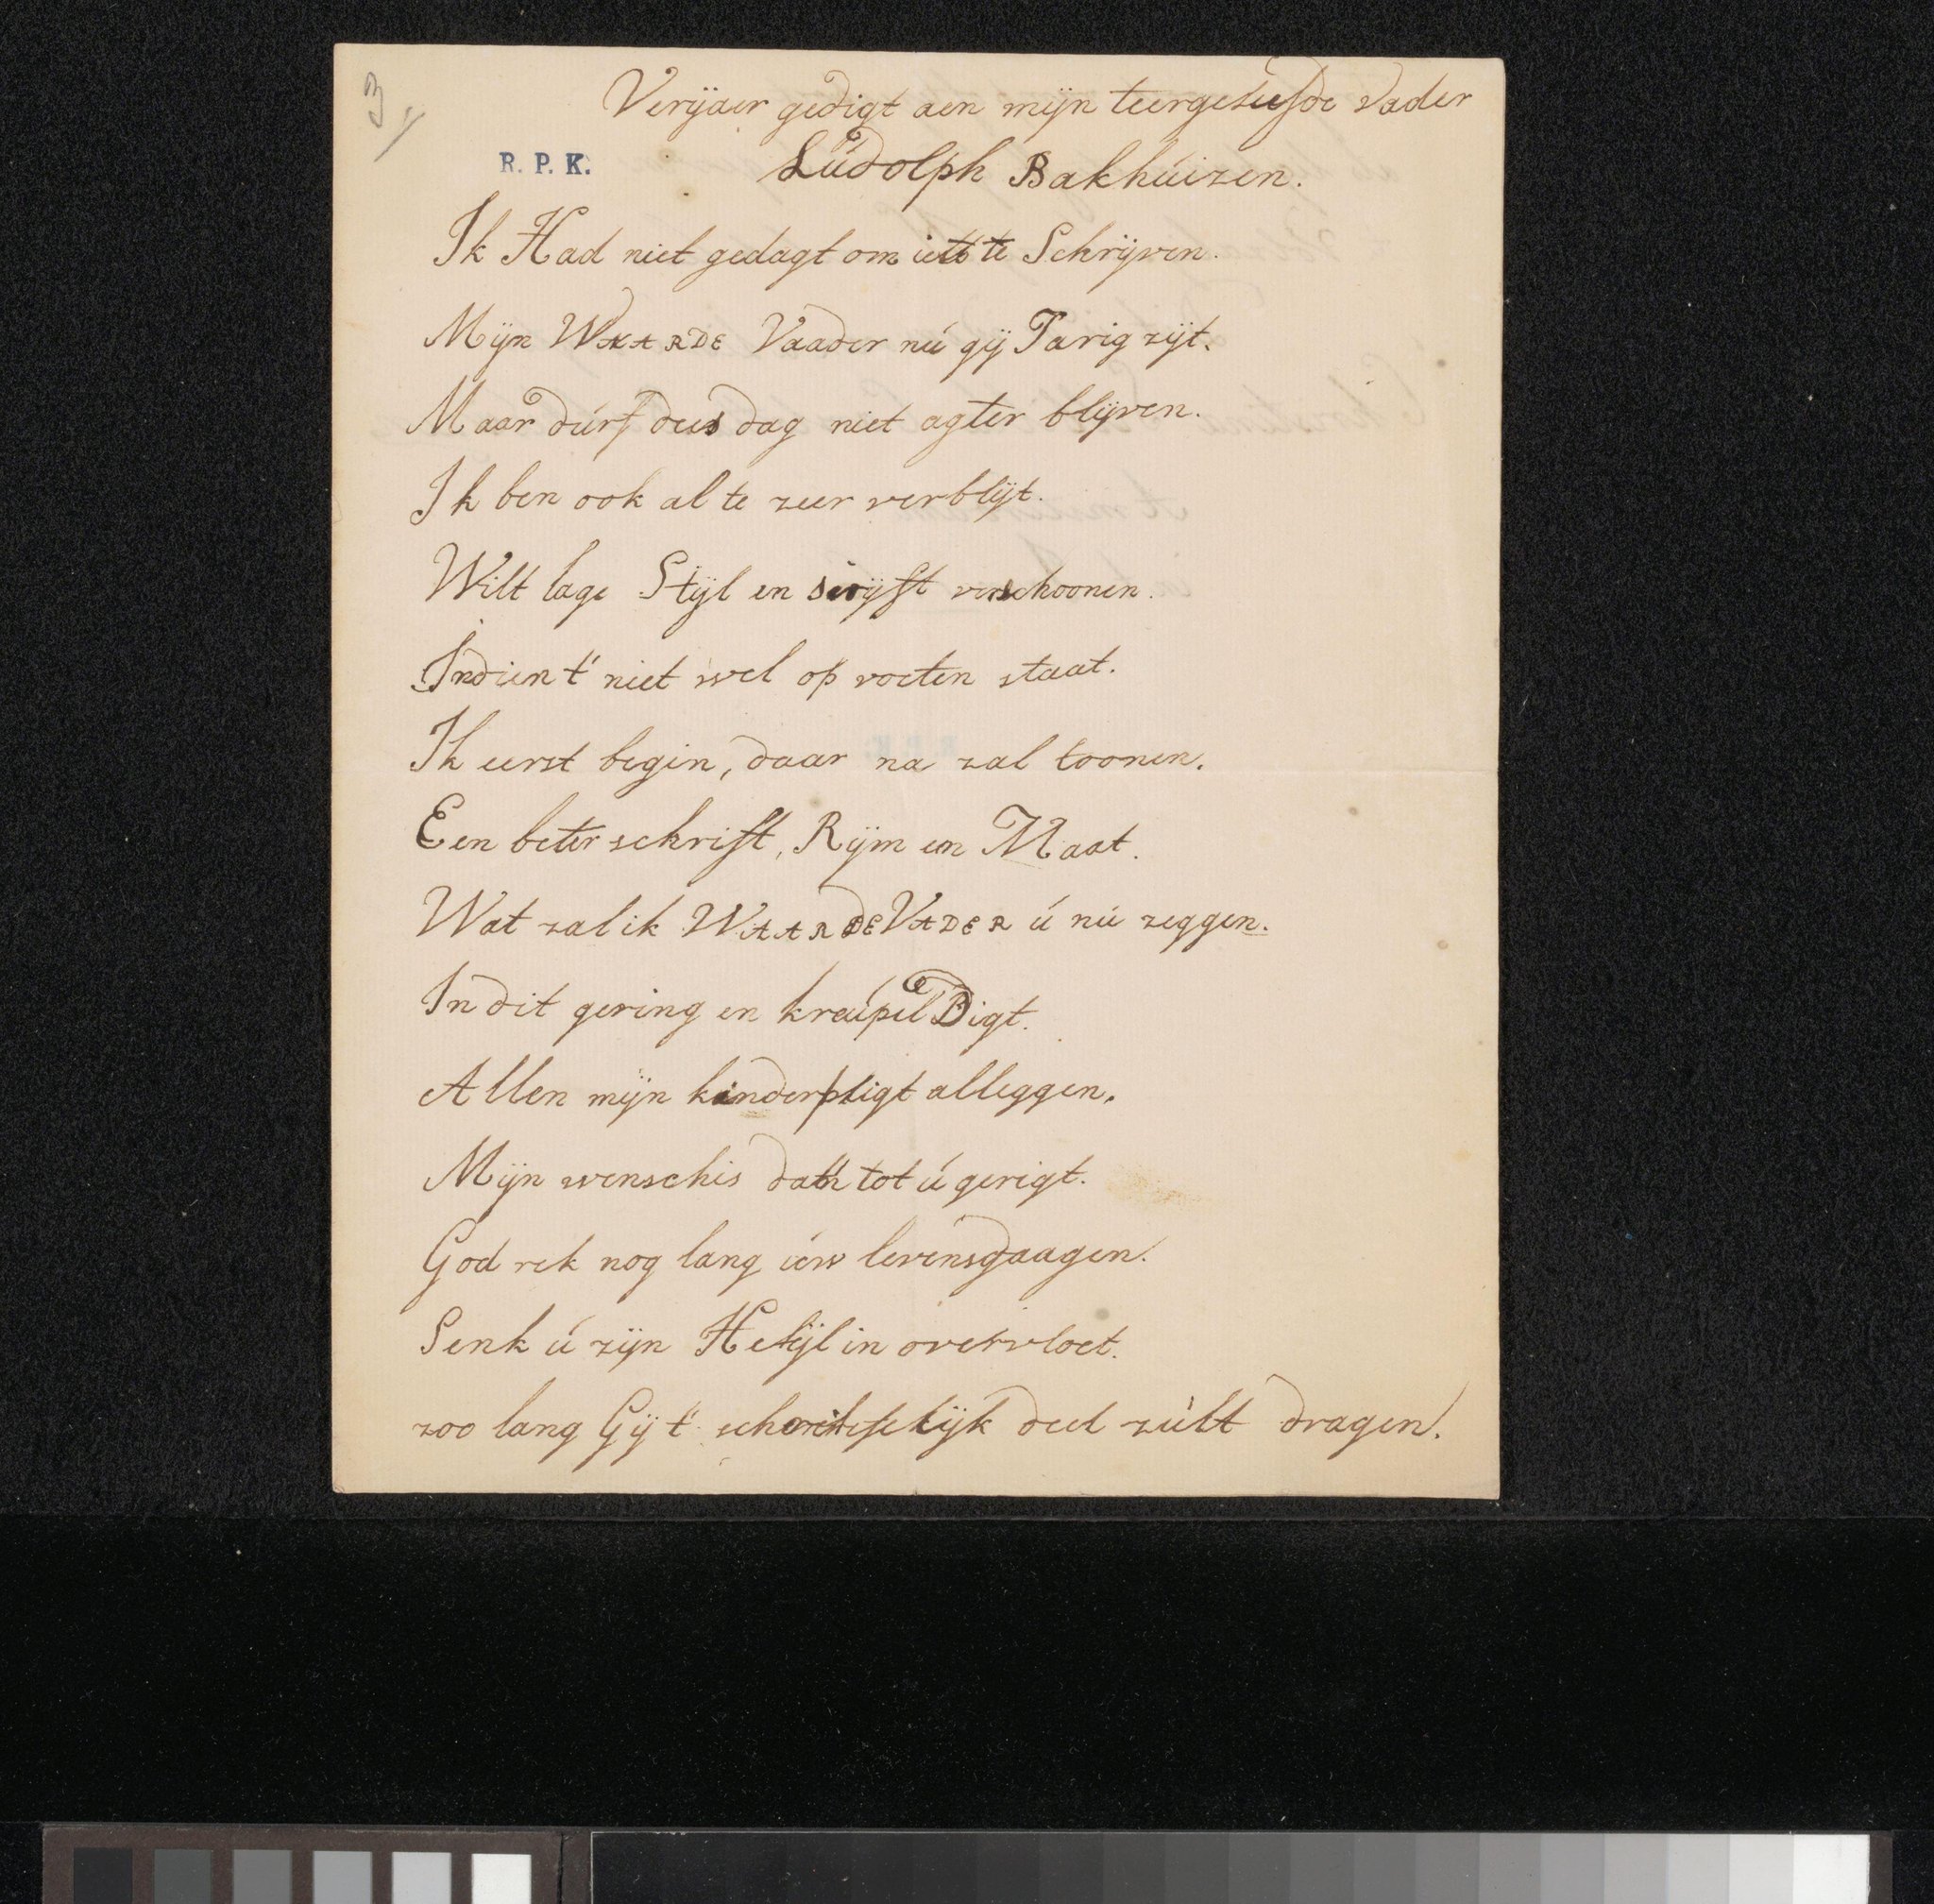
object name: poem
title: Gedicht aan Ludolf Backhuysen (II)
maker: christina sibilla charlotta bakhuizen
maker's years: 1750-1810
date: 1760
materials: ink, paper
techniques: pen, writing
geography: amsterdam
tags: painter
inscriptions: watermark, collector's mark: Lugt 2233